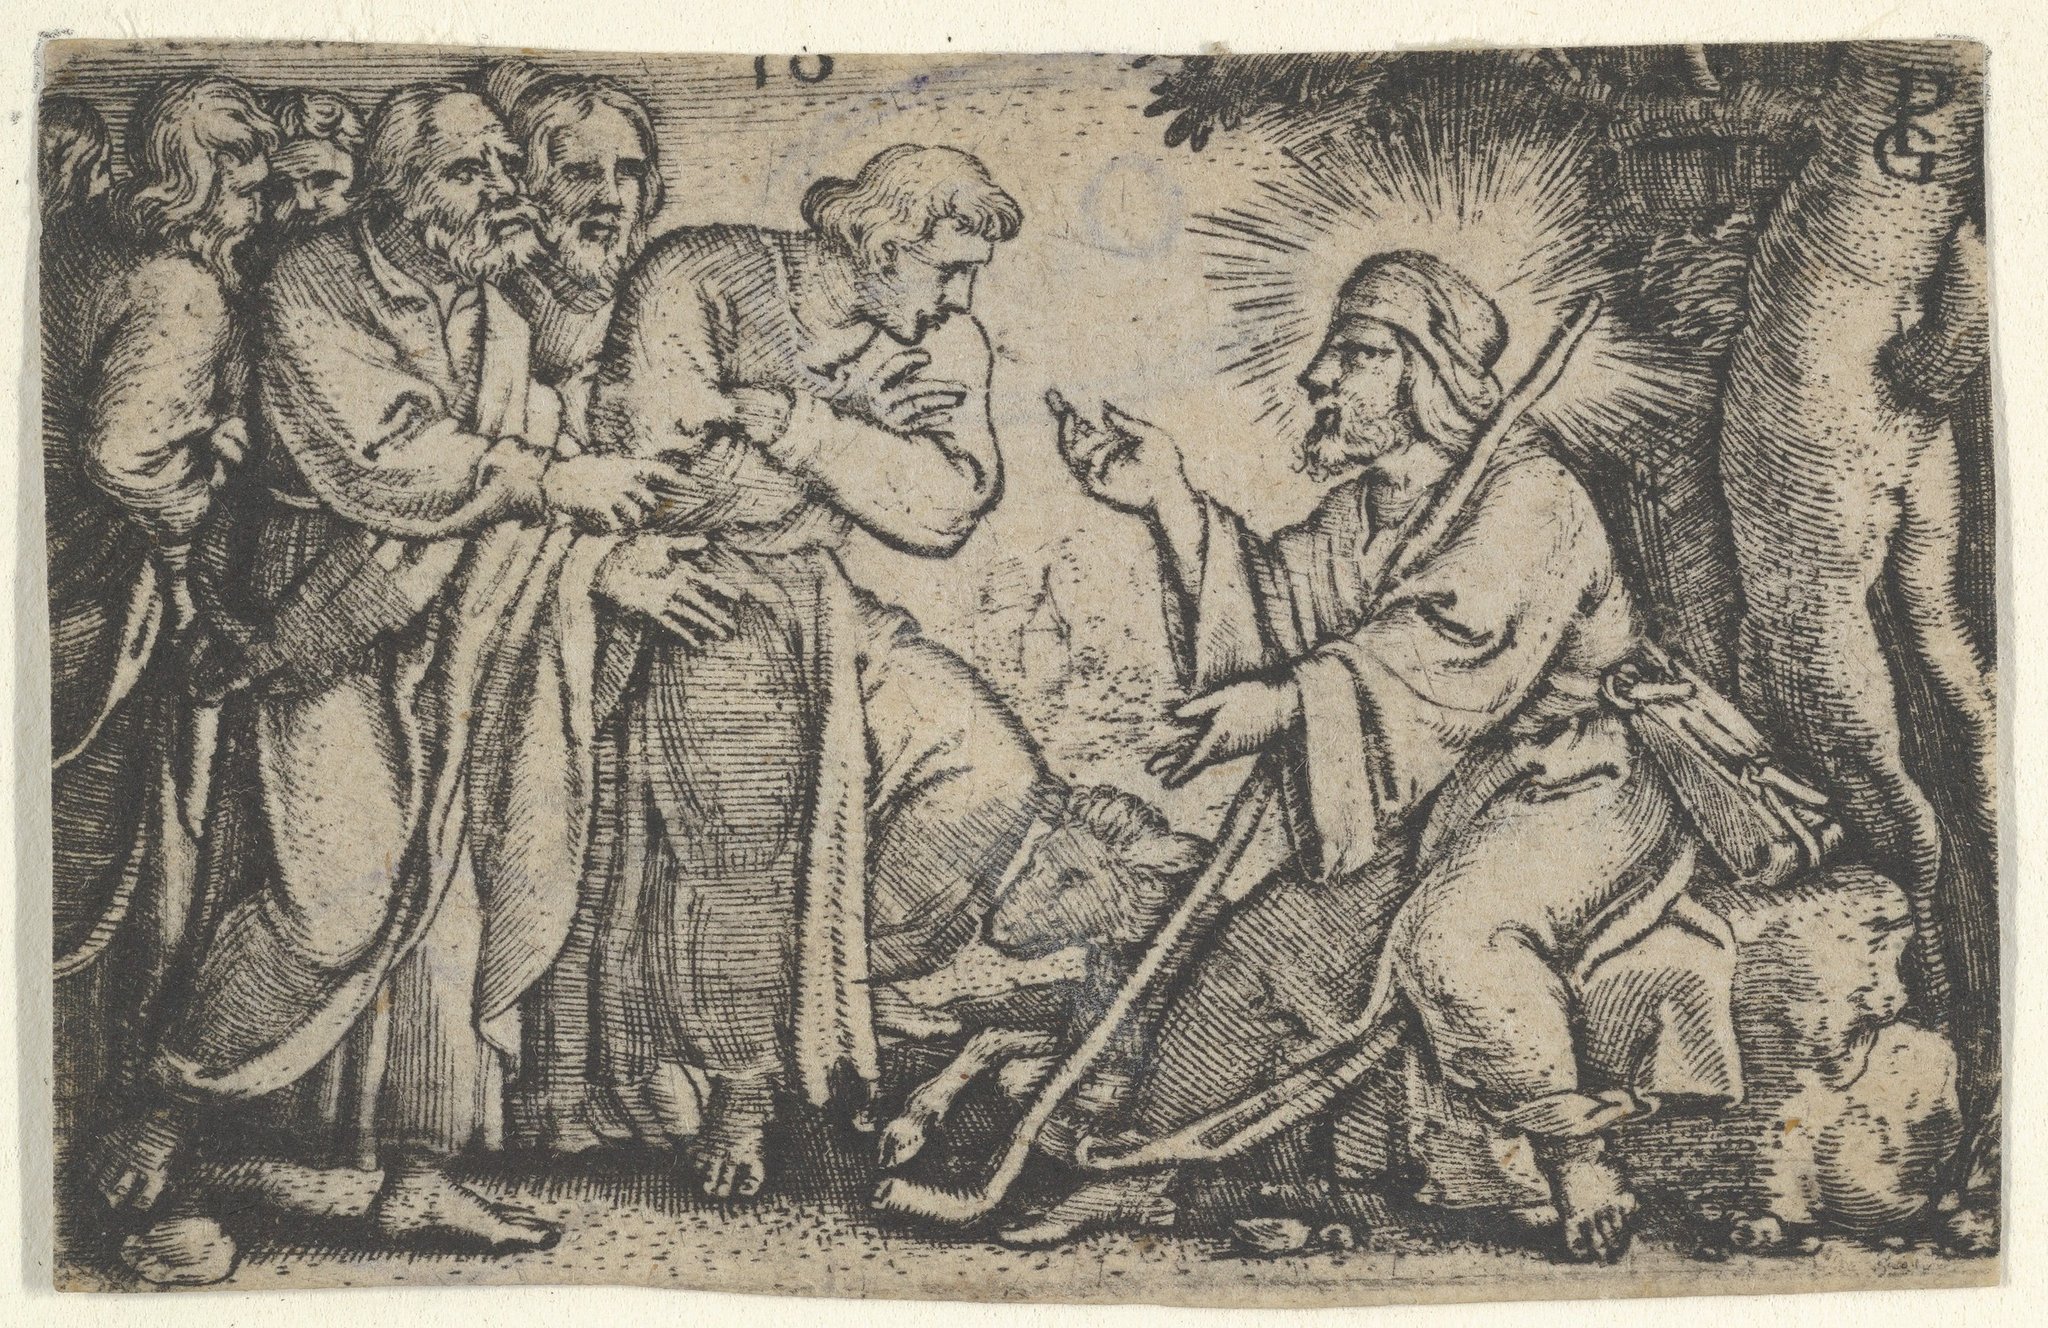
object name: print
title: Christ Speaking to the Disciples, from "The Story of Christ"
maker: georg pencz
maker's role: artist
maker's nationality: german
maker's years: 1500-1550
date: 1534-1535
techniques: engraving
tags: animals,men,christ